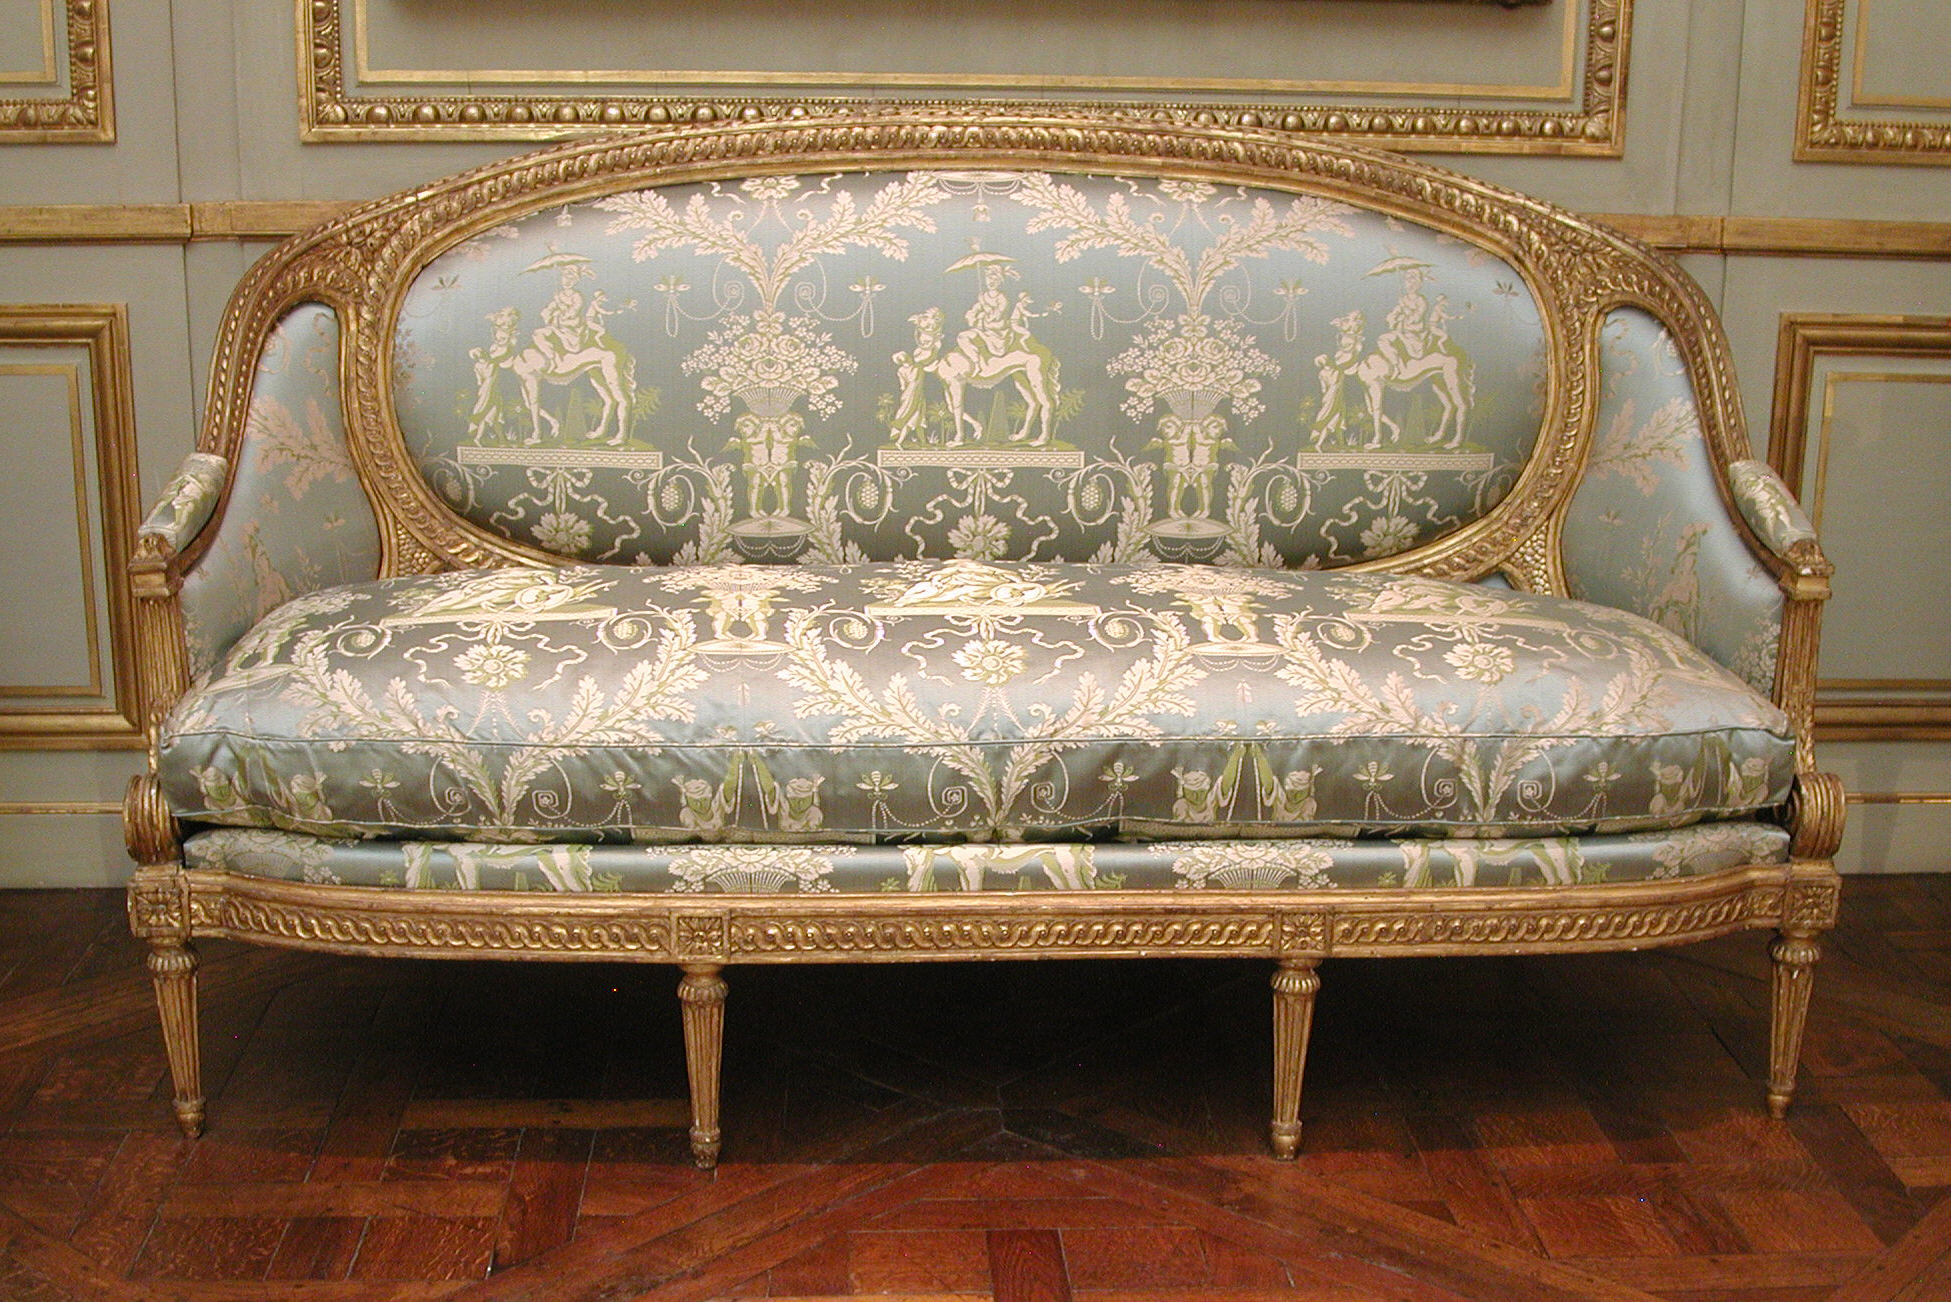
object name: sofa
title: Sofa (Canapé) (part of a set)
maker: sulpice brizard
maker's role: maker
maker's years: 1735-1798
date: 1770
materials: wood, silk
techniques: carving, damask, gilding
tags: camels